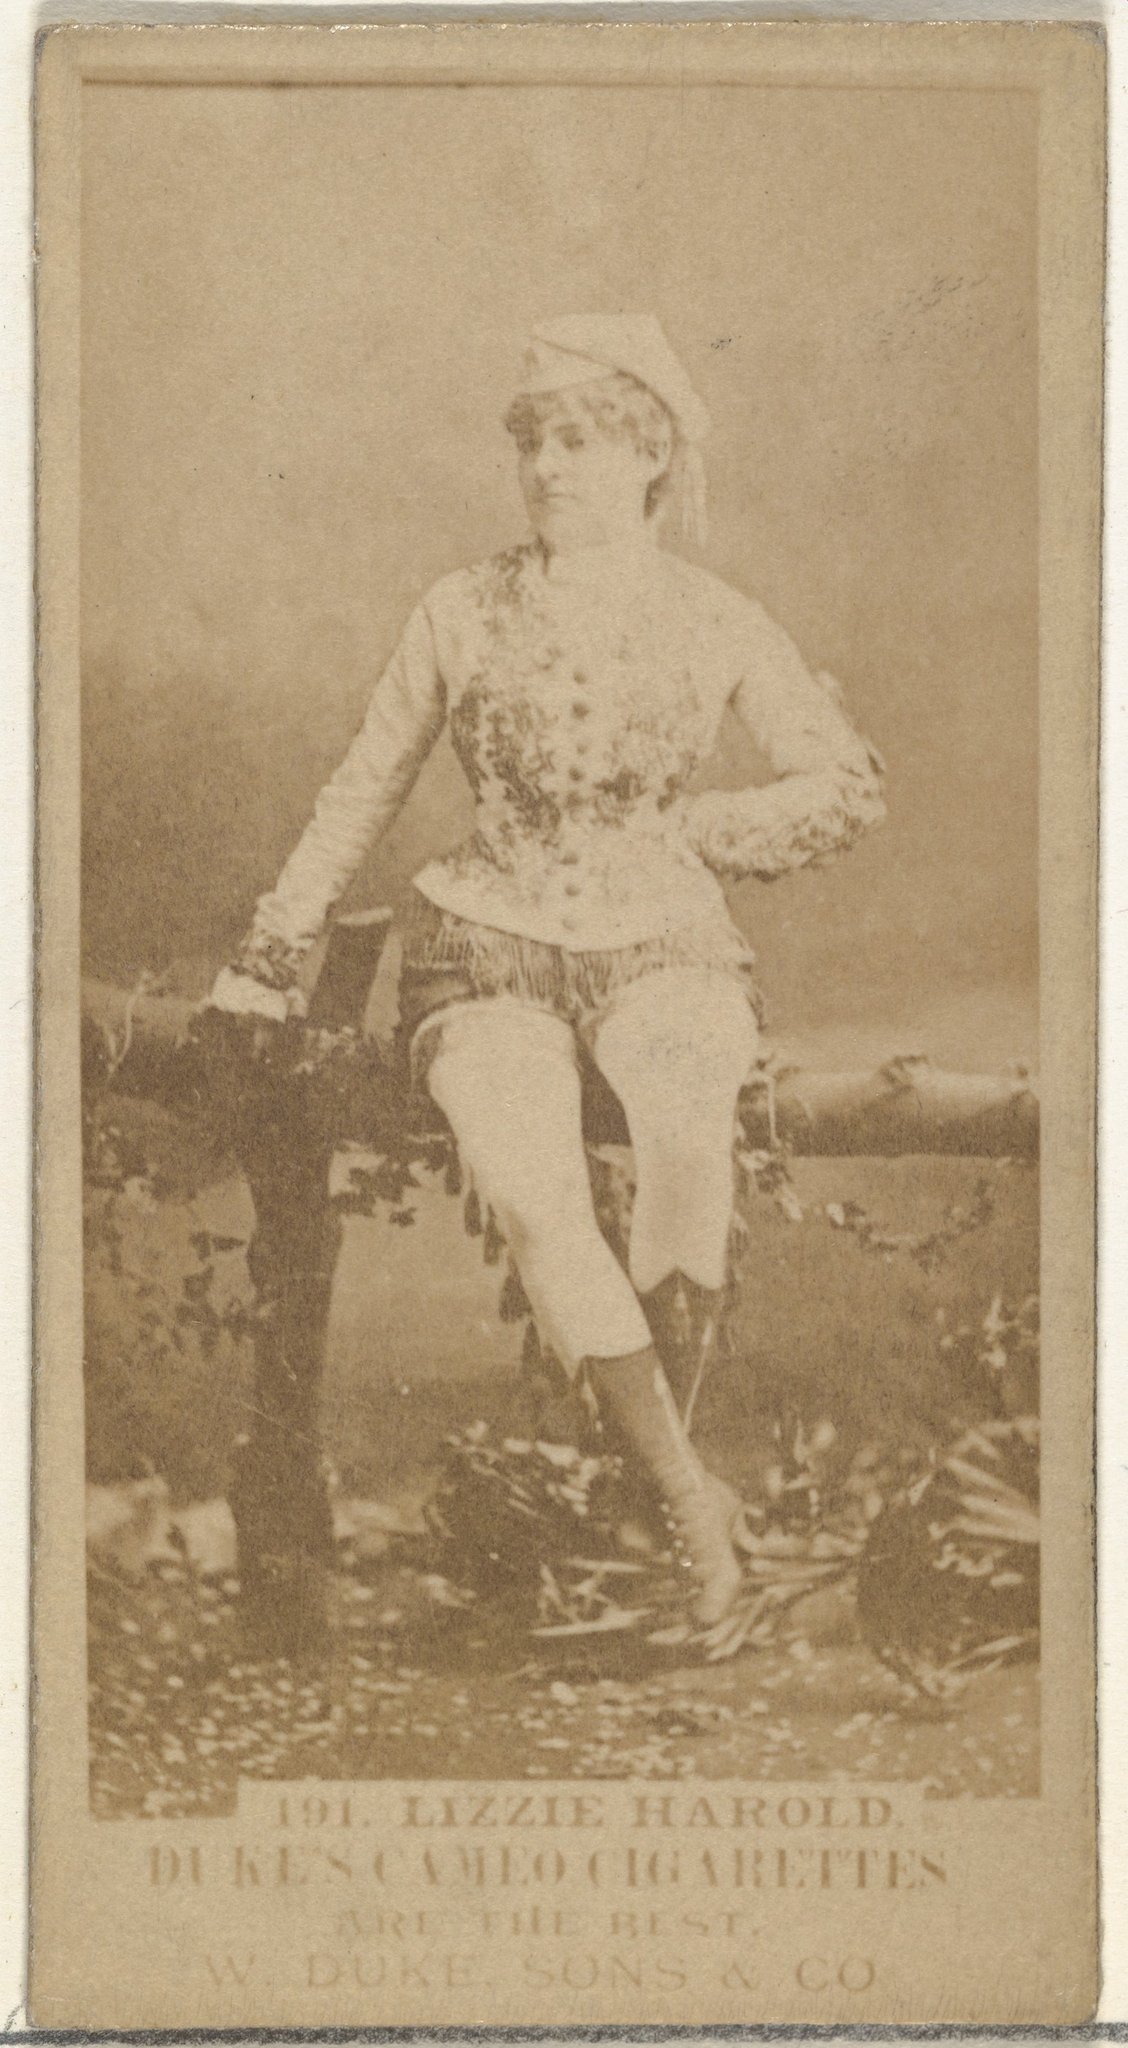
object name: photograph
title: Card Number 191, Lizzie Harold, from the Actors and Actresses series (N145-5) issued by Duke Sons & Co. to promote Cameo Cigarettes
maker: w. duke, sons & co.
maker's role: publisher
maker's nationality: american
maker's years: 1870-1920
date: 1880-1889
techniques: albumen silver print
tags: portraits,women,actresses